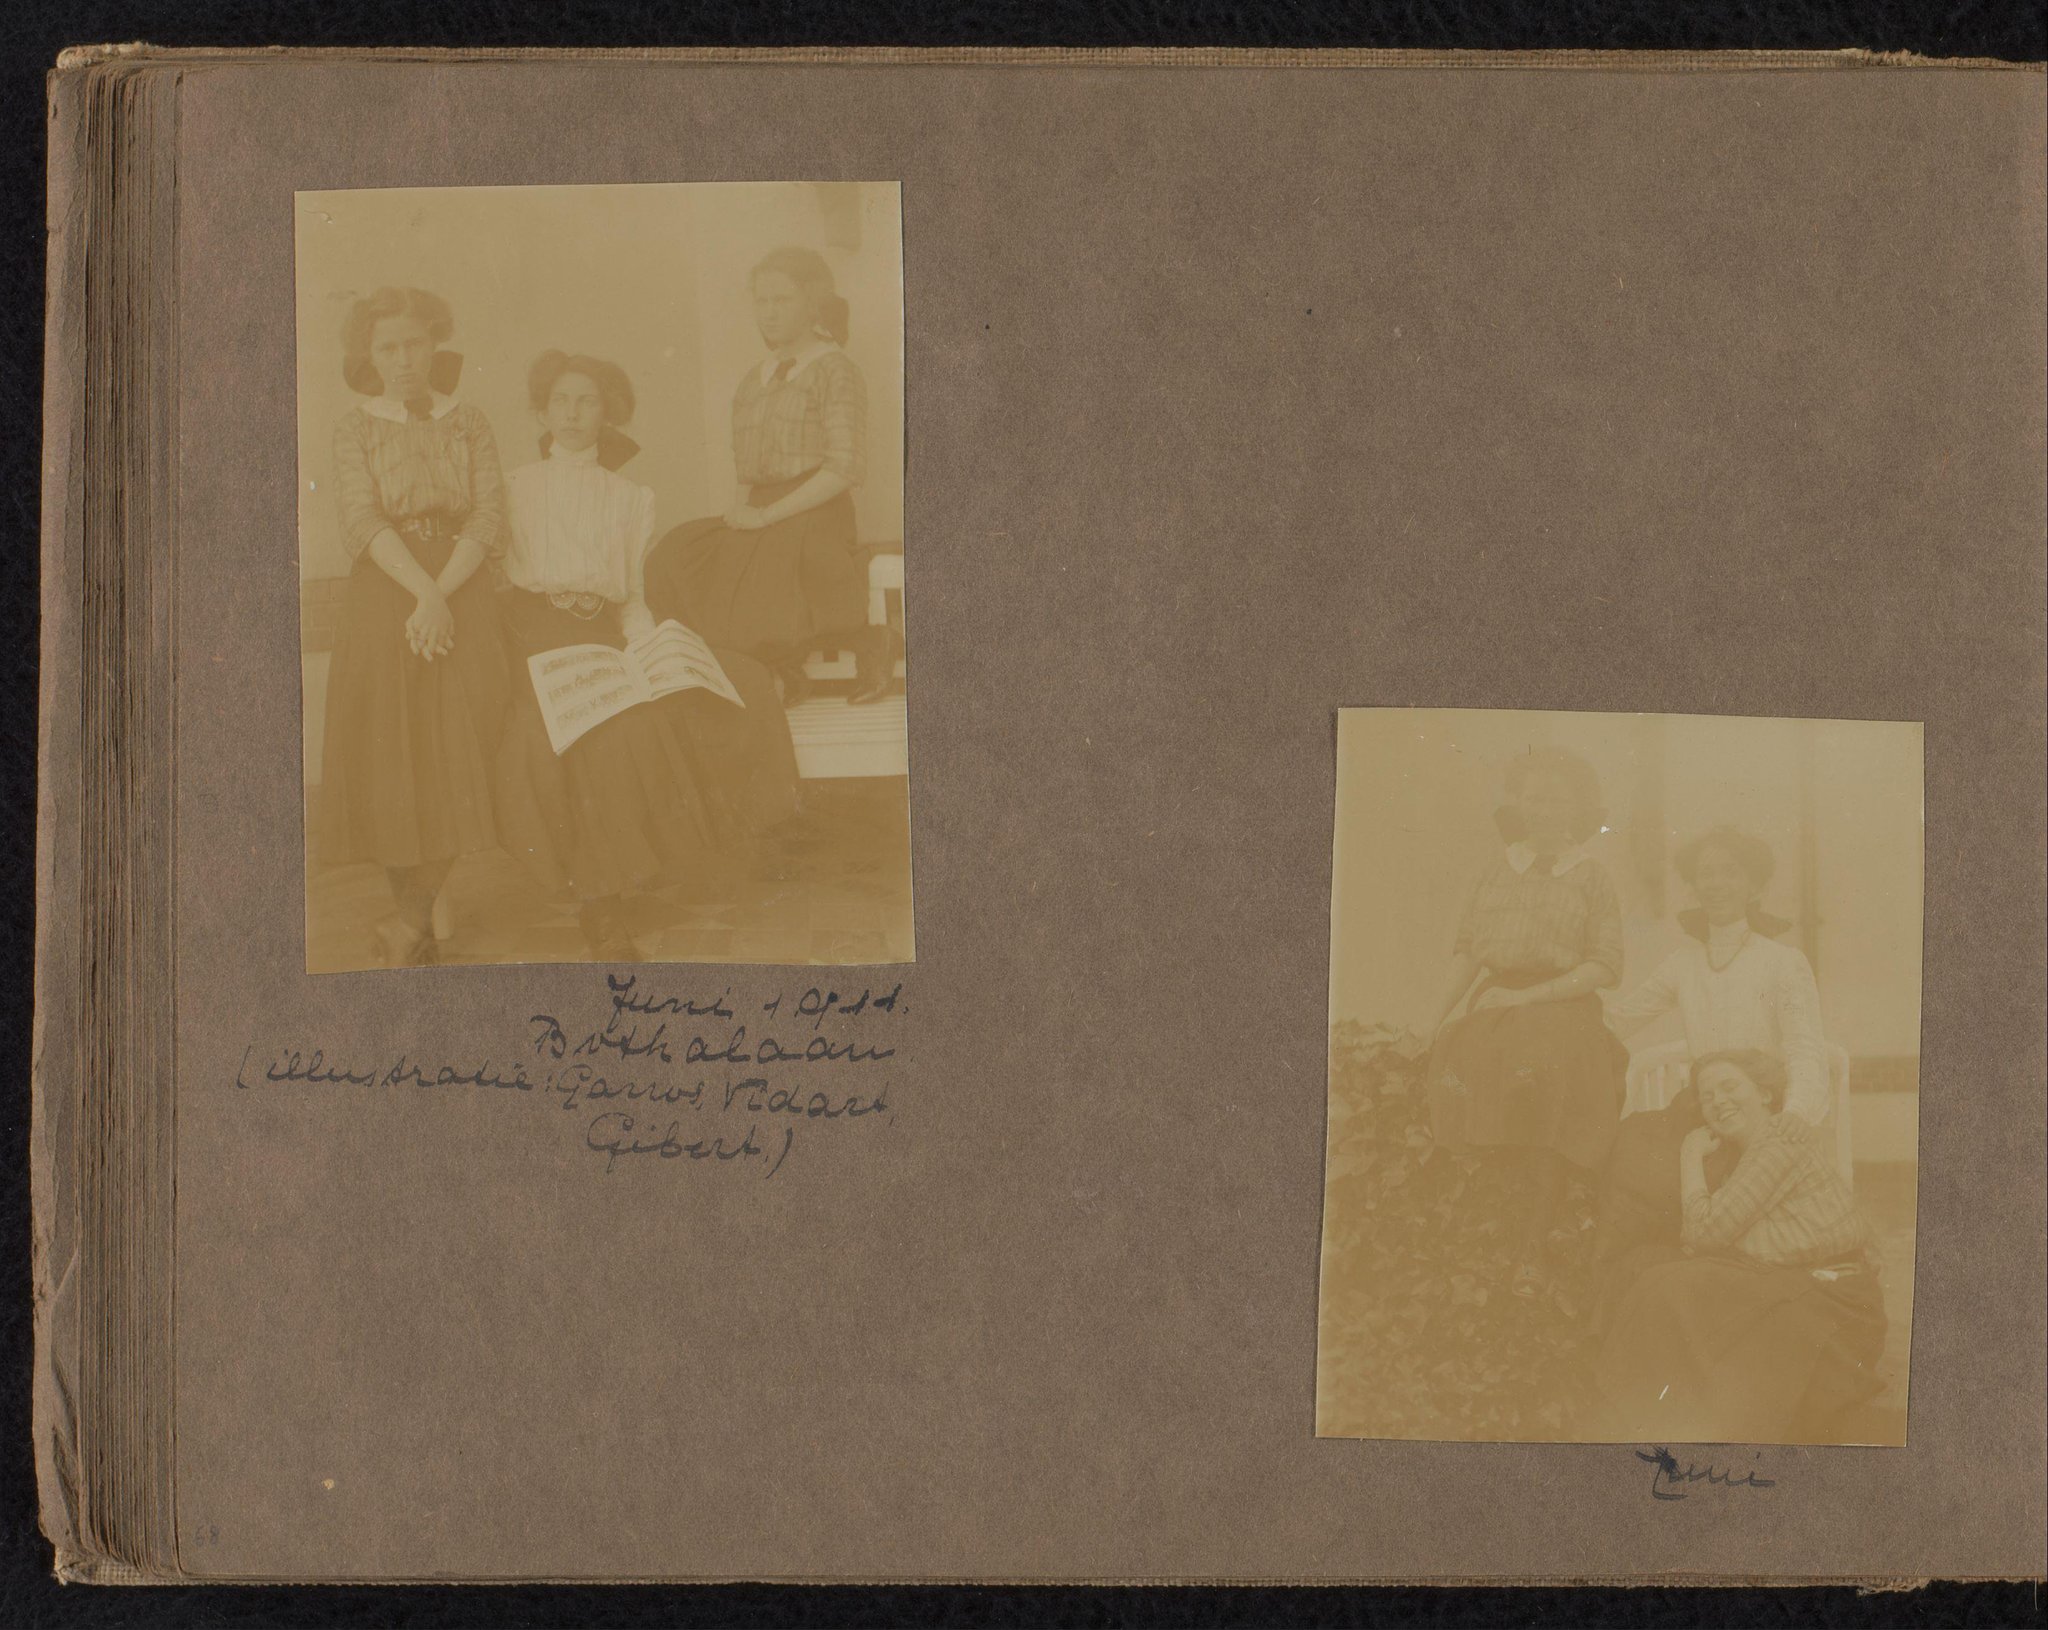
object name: album leaf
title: Twee groepsportretten van Milly en Loentje Onnen met een vriendin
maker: carolina frederika onnen (lien/loen)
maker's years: 1896-1983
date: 1906-1911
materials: paper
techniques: gelatin silver print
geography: hilversum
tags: amsterdam, carolina frederika onnen (lien/loen), historical persons - bb - woman, friends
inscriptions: inscription: ‘Juni’, inscription: ‘Juni 1911./ Bothalaan/ (illustratie: Garros, Vidart/ Gibert)’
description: Deze foto's maken deel uit van een album.